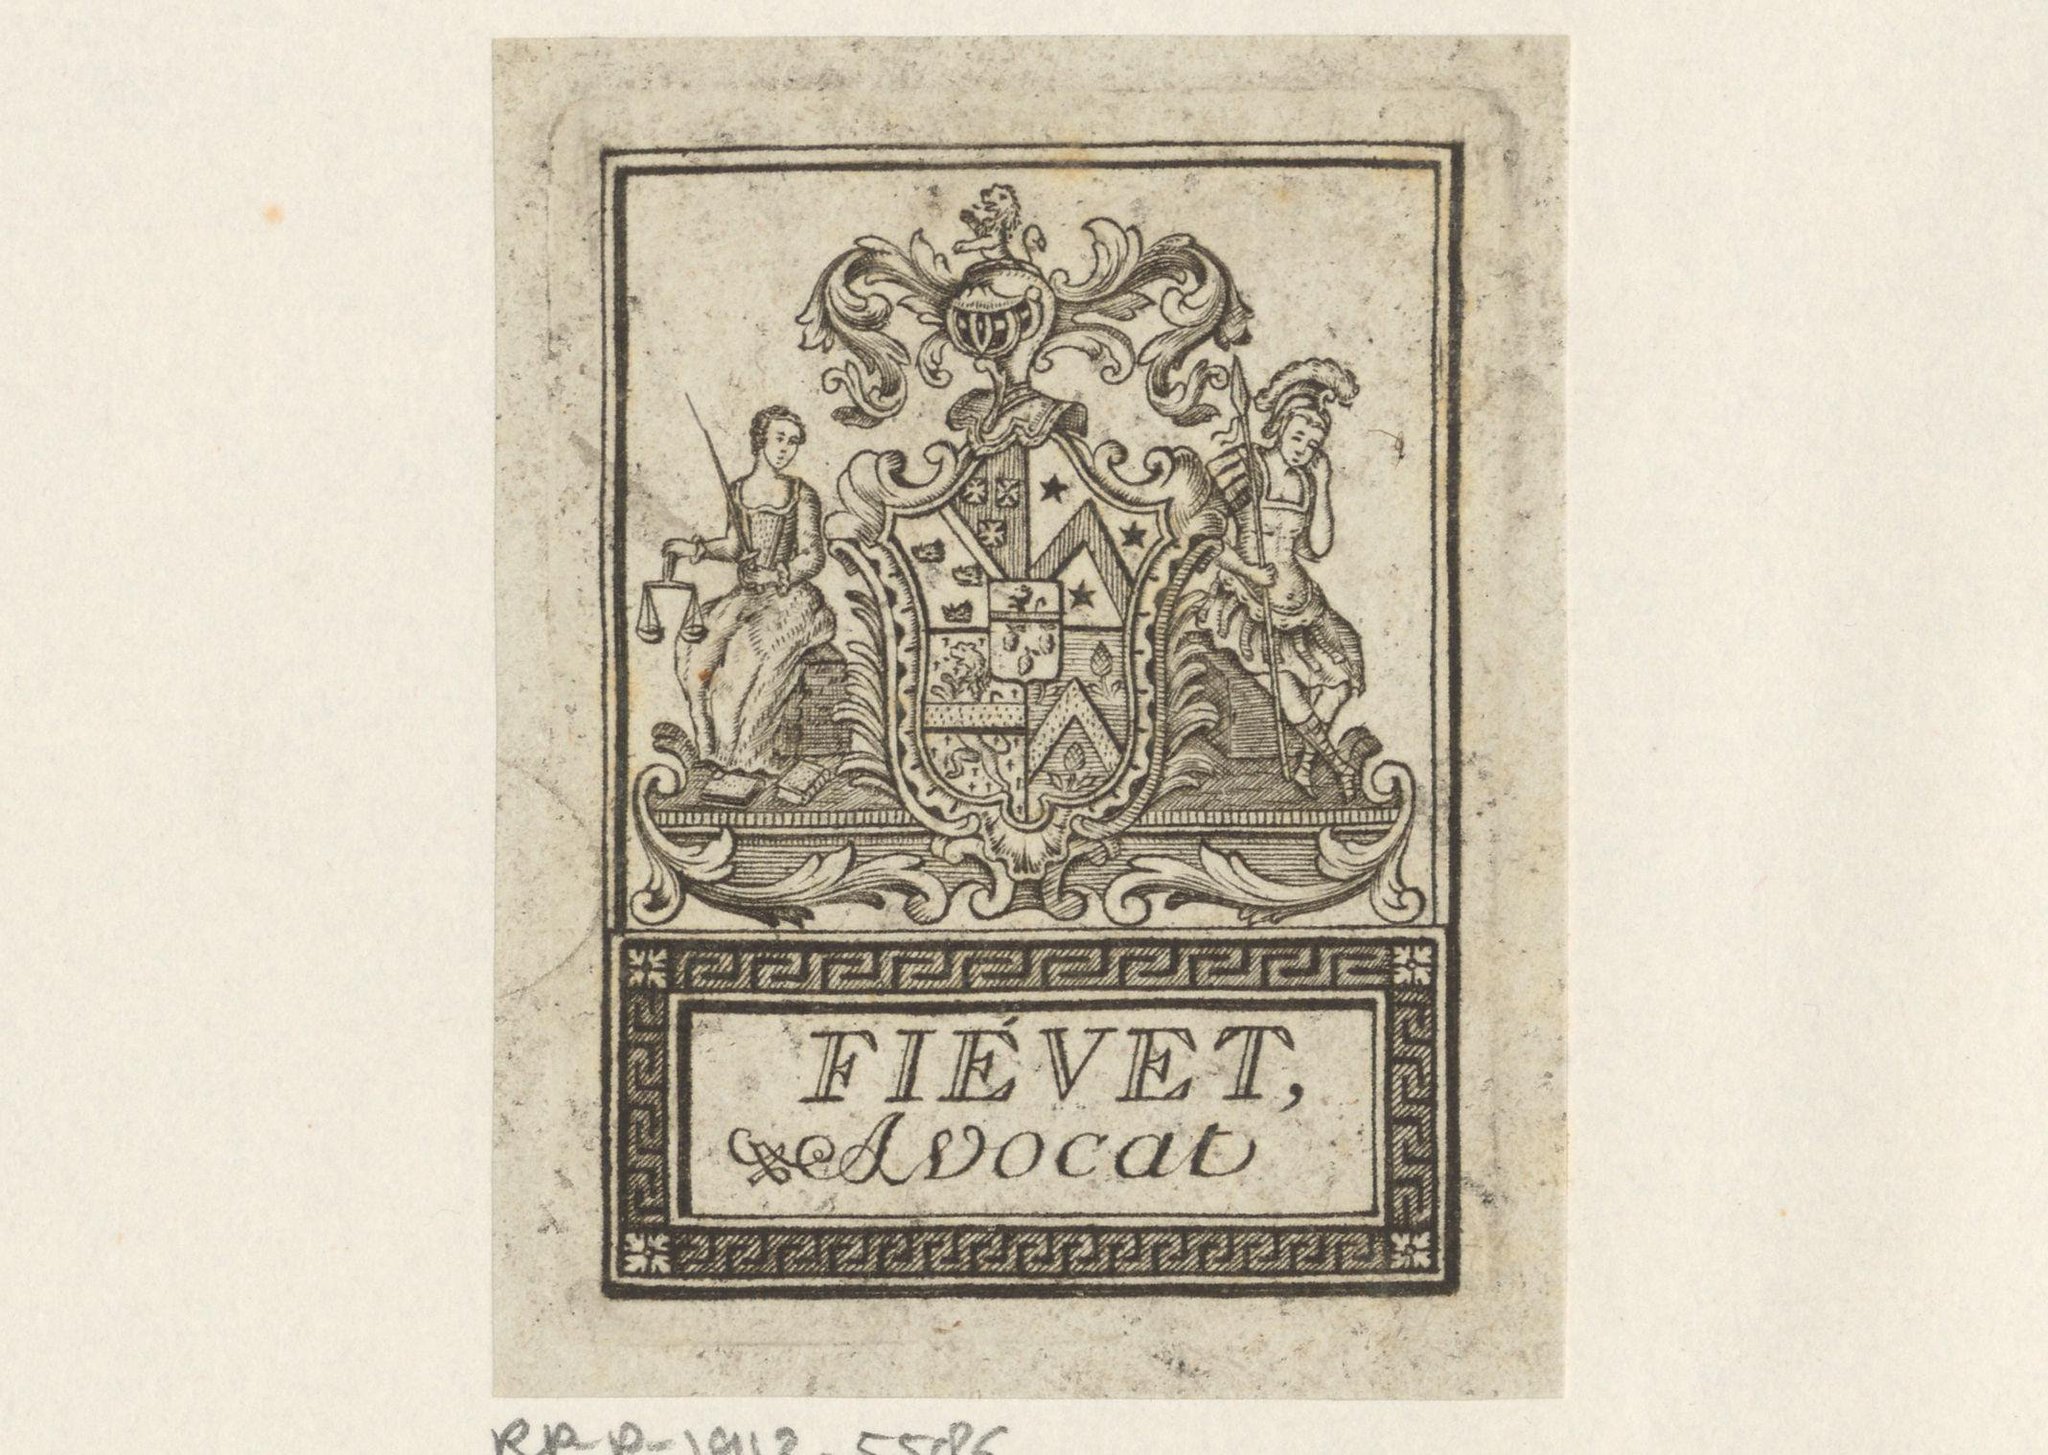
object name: bookplate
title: Fiévet avocat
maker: Anonymous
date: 1700-1849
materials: paper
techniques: etching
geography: france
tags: sitting figure - aa - female human figure, book, law and jurisprudence, armorial bearing, heraldry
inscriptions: collector's mark: Lugt 2233, collector's mark: Lugt 2760